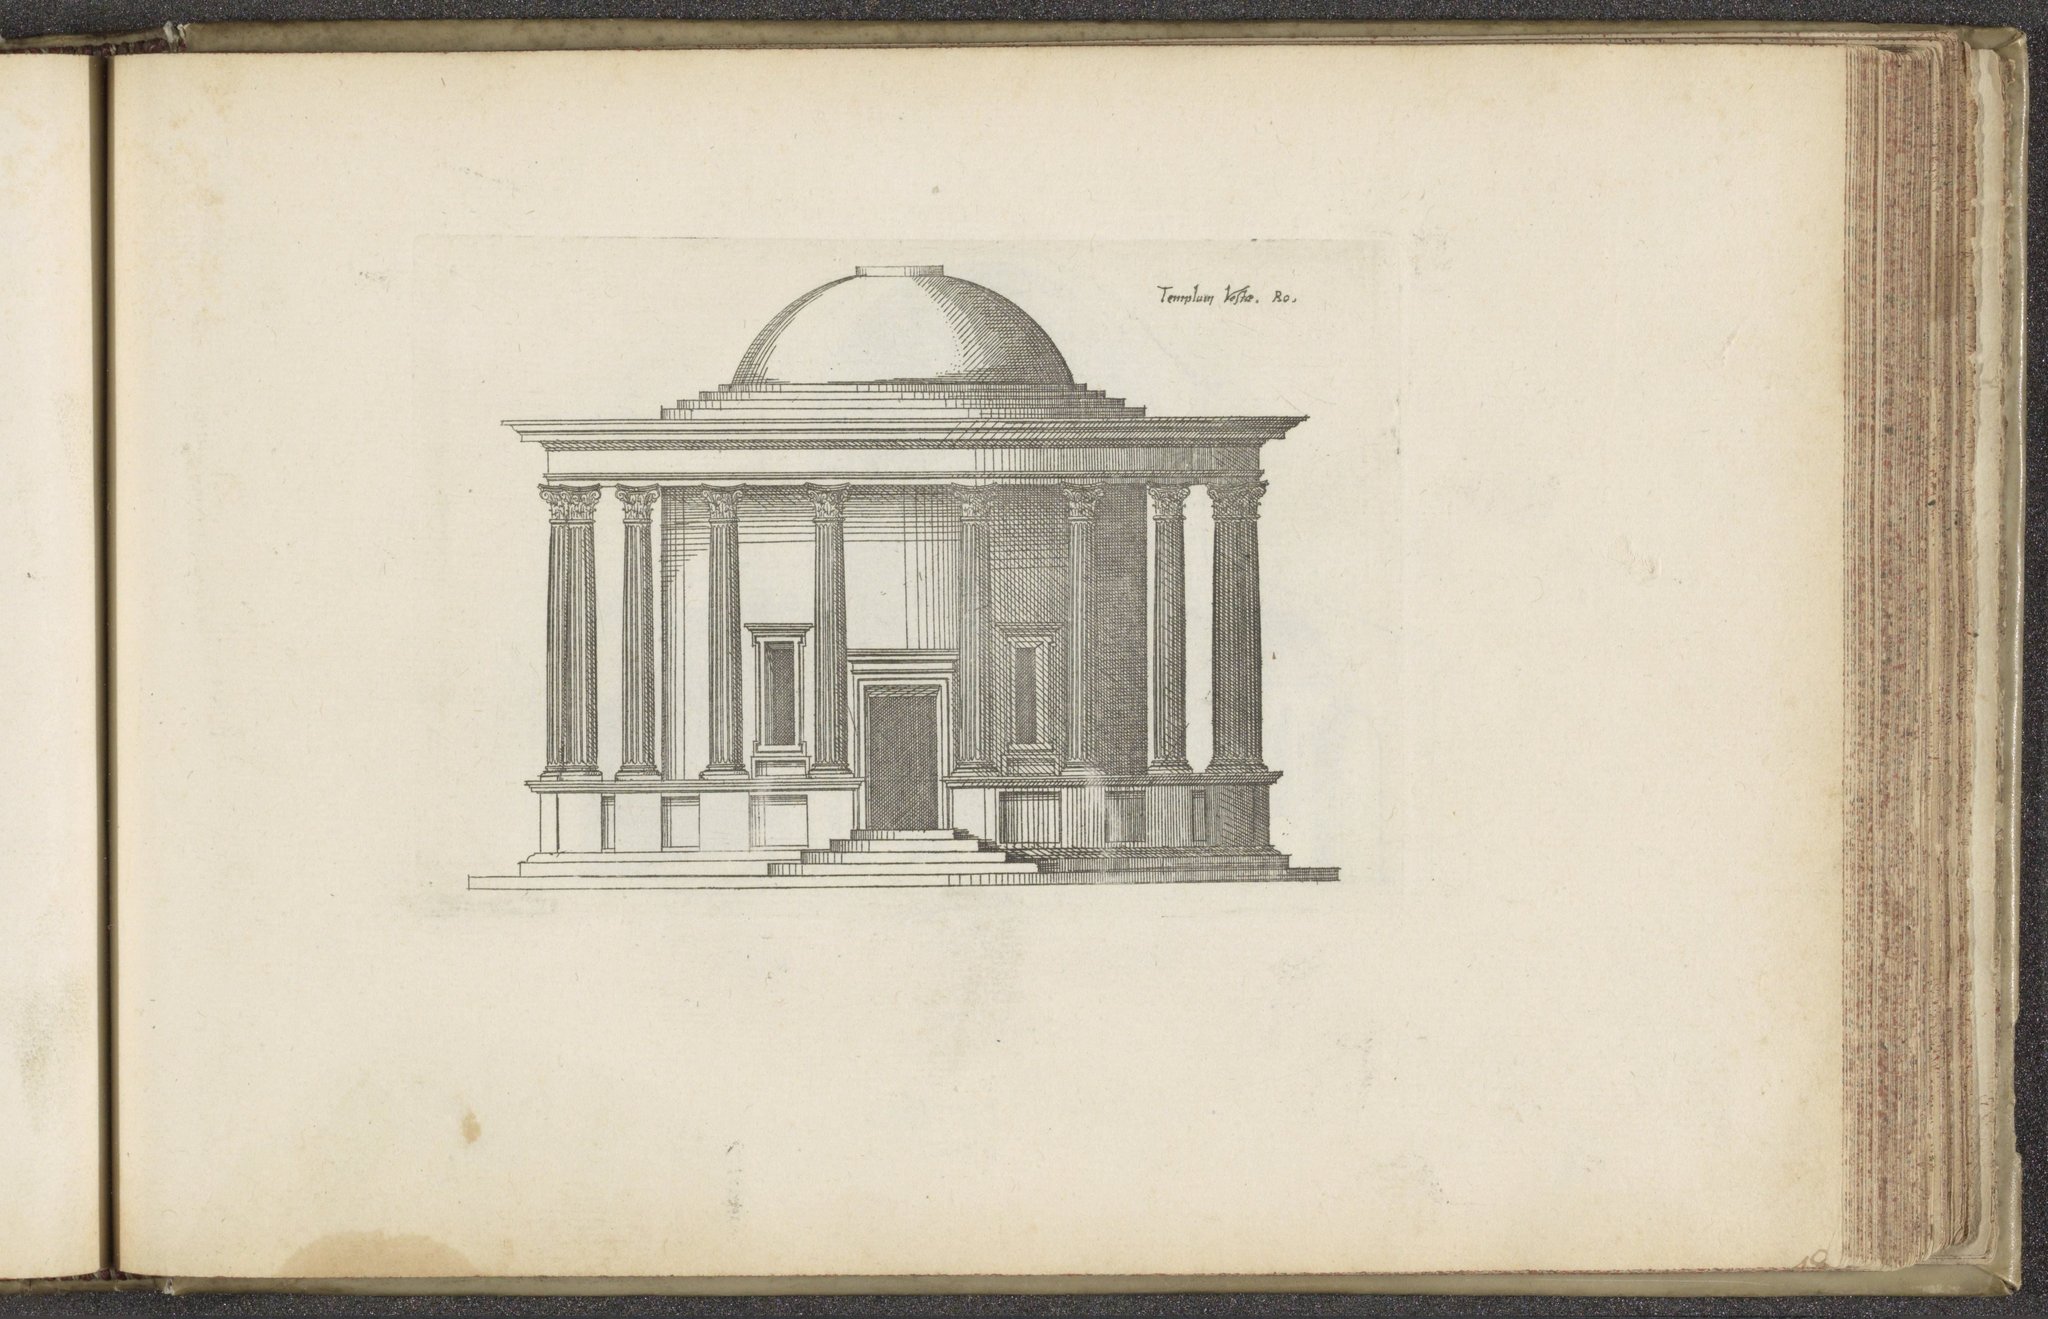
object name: album leaf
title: Templum Vesta Ro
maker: jacques androuet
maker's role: draughtsman, print maker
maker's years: 1515-1584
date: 1550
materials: paper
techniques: etching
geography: orléans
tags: temple, shrine ~ roman religion, exterior ~ representation of a building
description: Ronde tempel van Vesta. Deze prent maakt deel uit van een album.